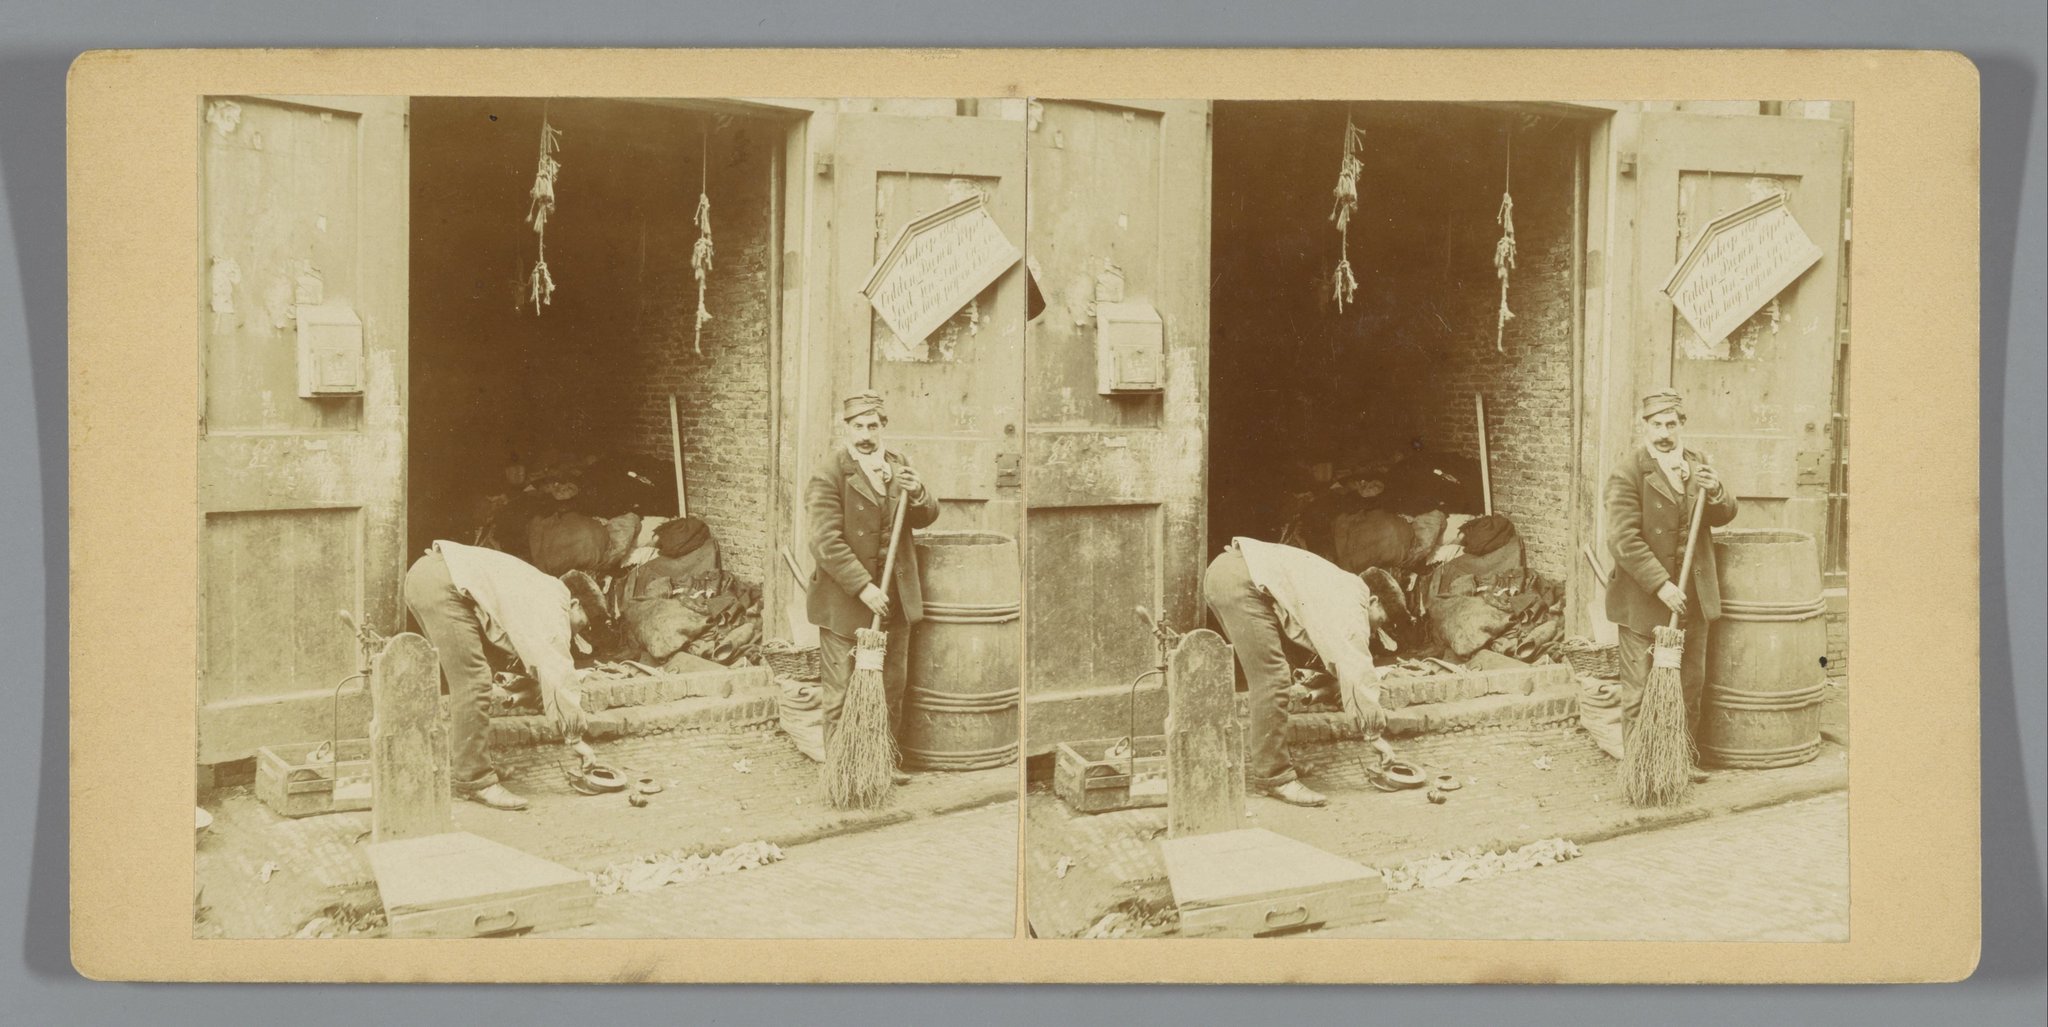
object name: stereograph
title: Twee personen voor een voddenhuis in Amsterdam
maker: Anonymous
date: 1890-1930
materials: paper, cardboard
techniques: gelatin silver print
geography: amsterdam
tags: large-scale structure for storage, e.g.: warehouse, depot, silo, amsterdam